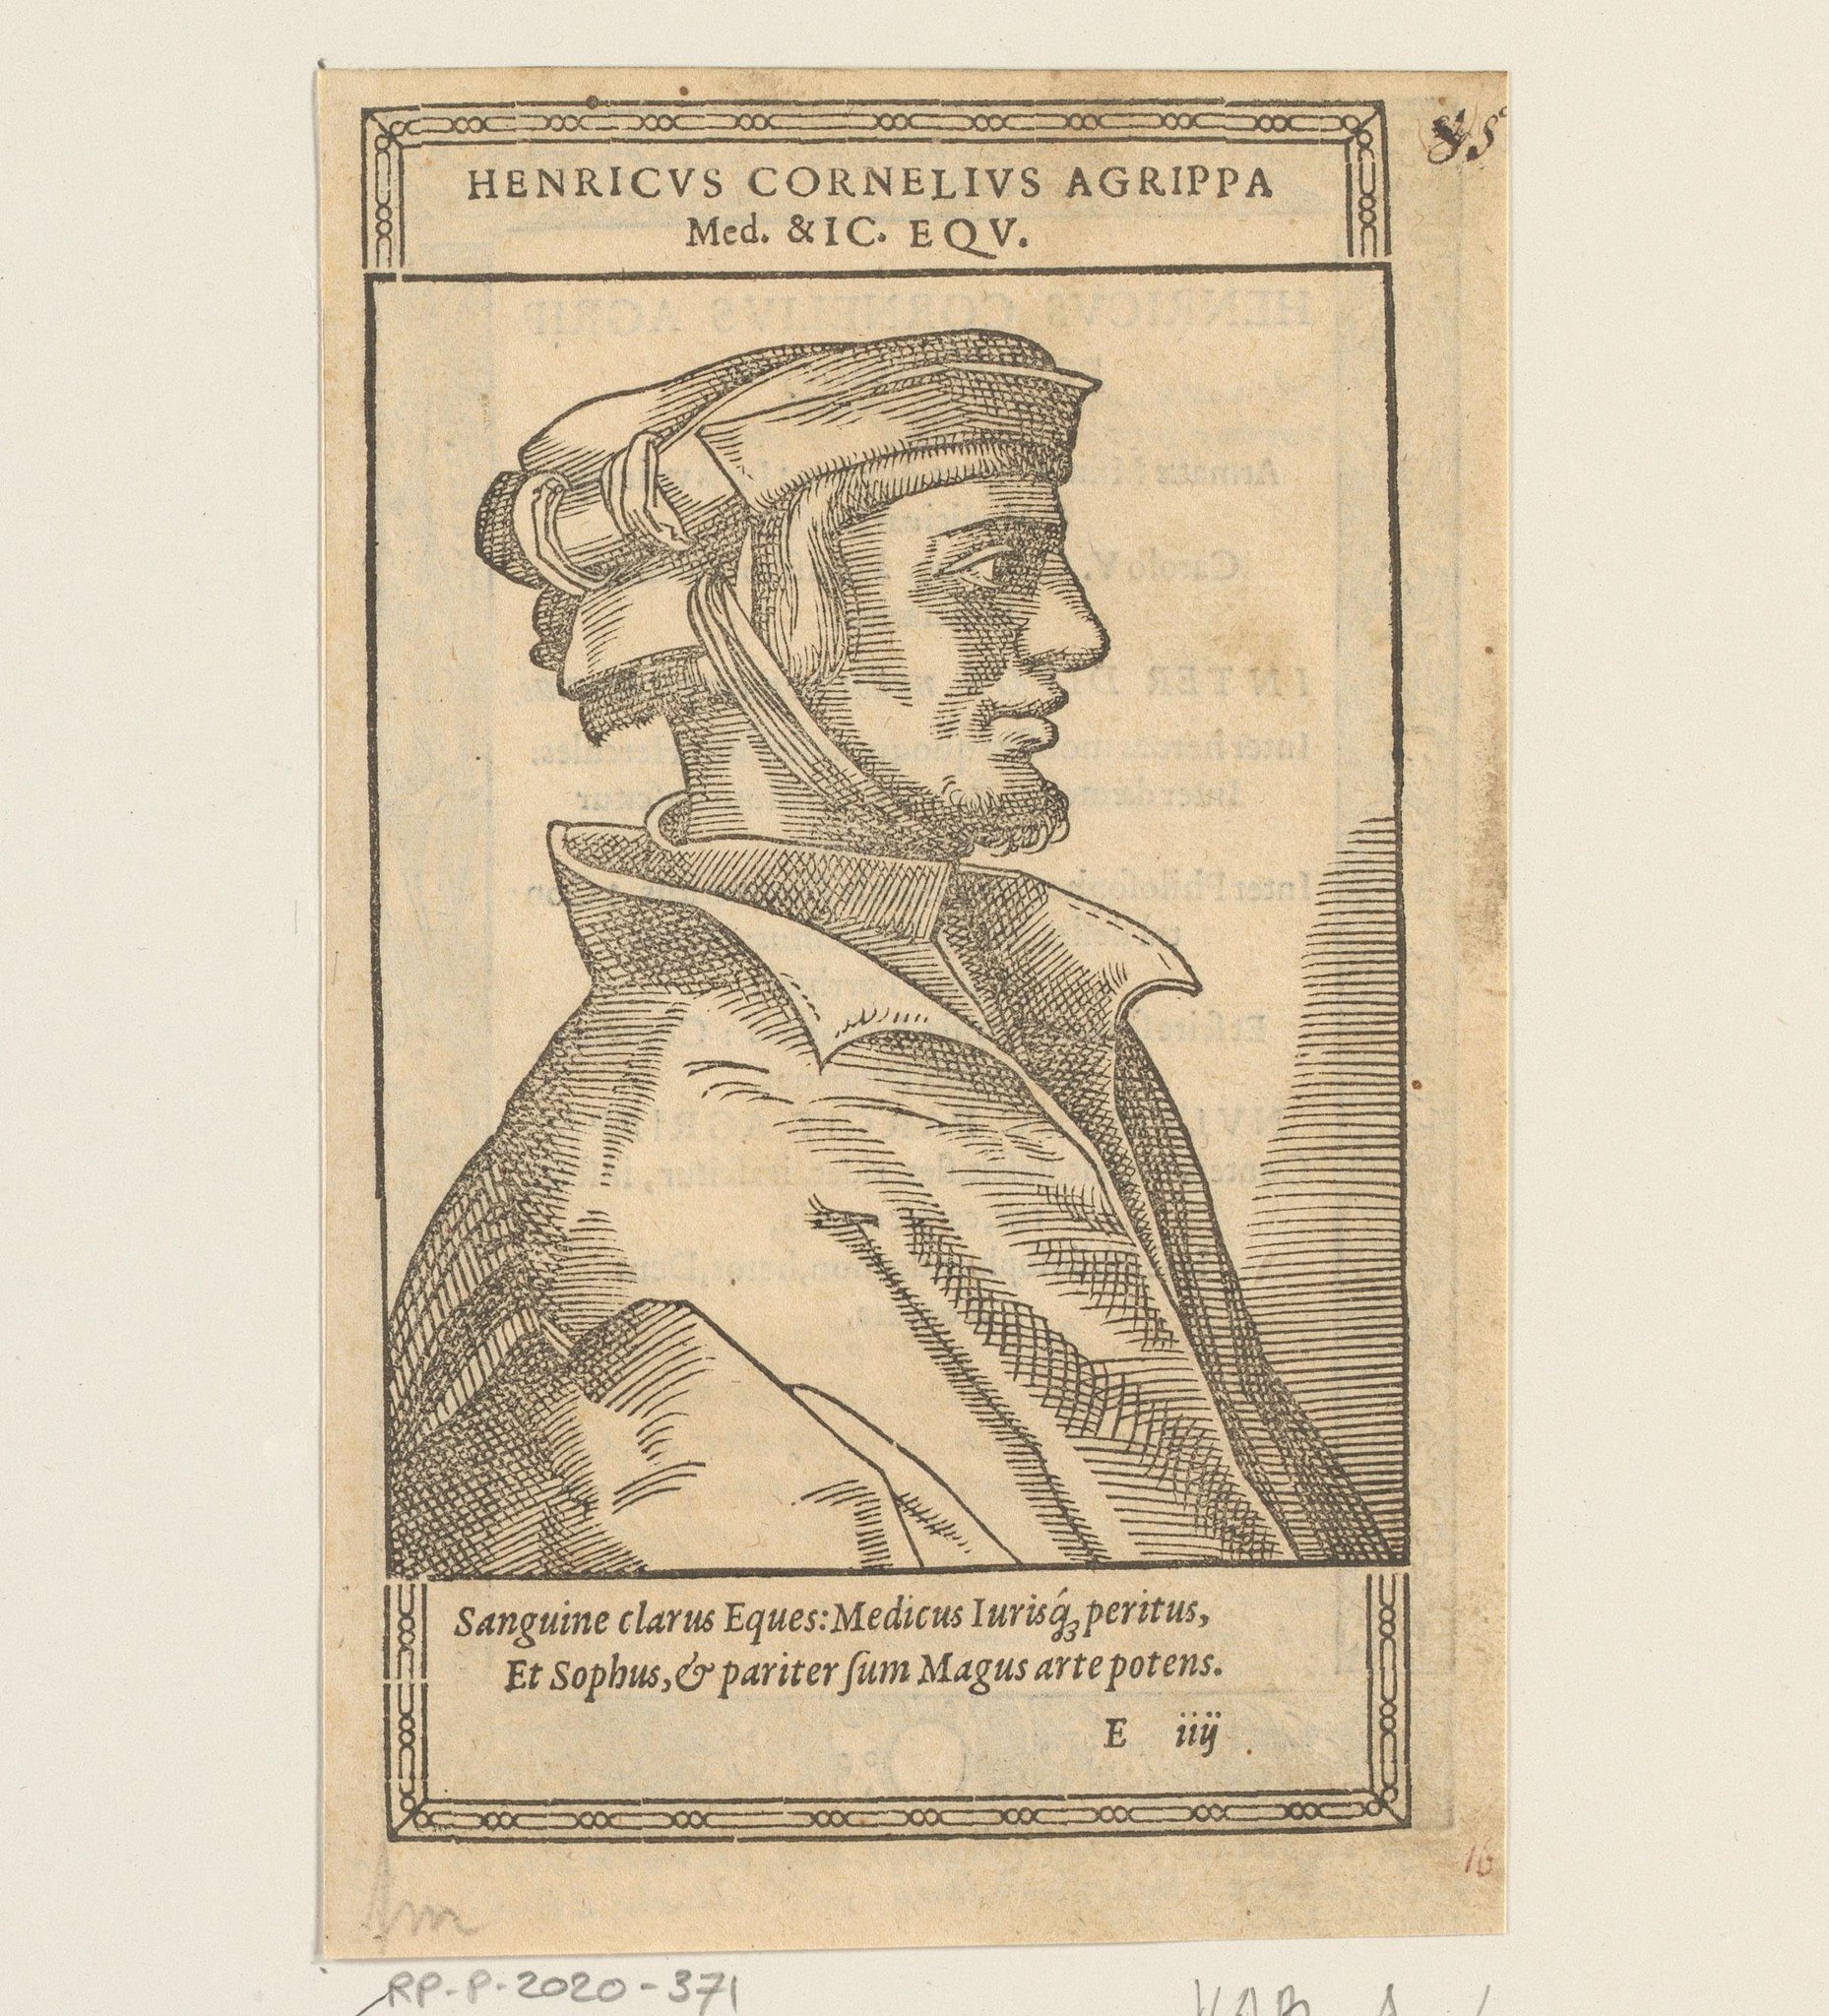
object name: print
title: Portret van Heinrich Cornelius Agrippa von Nettesheim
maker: bernhard jobin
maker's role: printer, publisher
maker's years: 1545-1593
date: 1587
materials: paper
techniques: letterpress printing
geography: straatsburg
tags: cologne, historical persons, portrait of a writer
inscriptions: inscription: ‘[...]’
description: Prent uit: Reusner, Nikolaus. Icones sive imagines virorum literis illustrium (...). Straatsburg: Bernhard Jobin, 1587. Prent ook gebruikt in de Duitse editie, uitgegeven in hetzelfde jaar, en de 1590-editie. Prent ook gebruikt in latere publicaties.